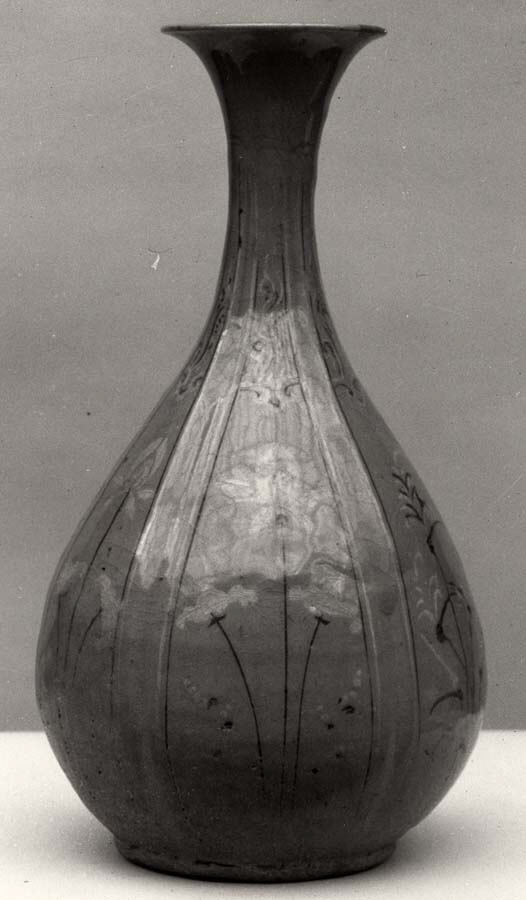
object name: vase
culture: korean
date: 1301-1350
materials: clay